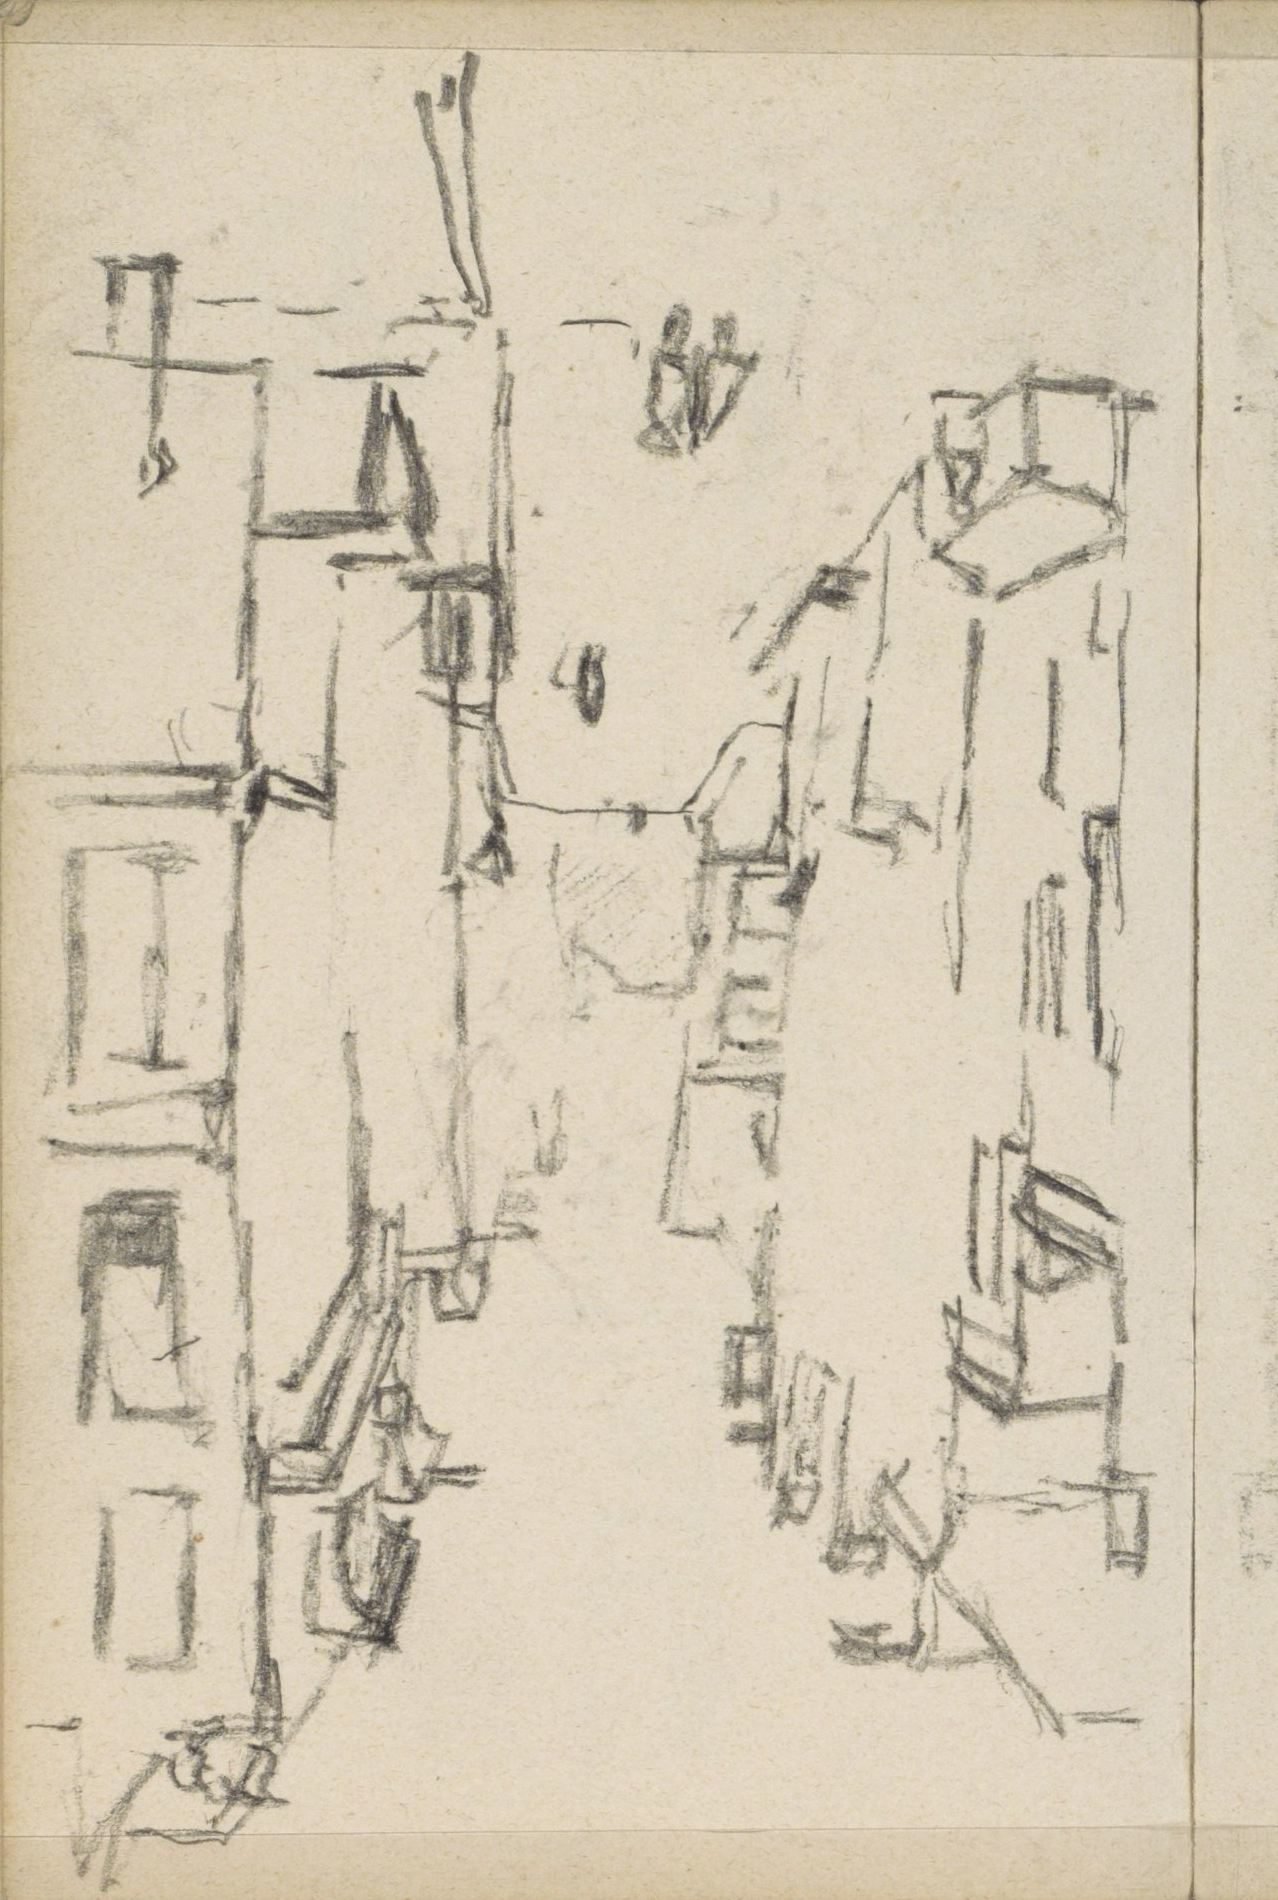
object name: sketchbook leaf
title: Gezicht op een straat in Amsterdam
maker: george hendrik breitner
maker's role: draughtsman, painter, print maker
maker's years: 1857-1923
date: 1907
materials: chalk, paper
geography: amsterdam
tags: urban housing, street, amsterdam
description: Gezicht op een straat in Amsterdam. Pagina 71 uit een schetsboek met 46 bladen vervaardigd in Amsterdam, Rotterdam en Haarlem.